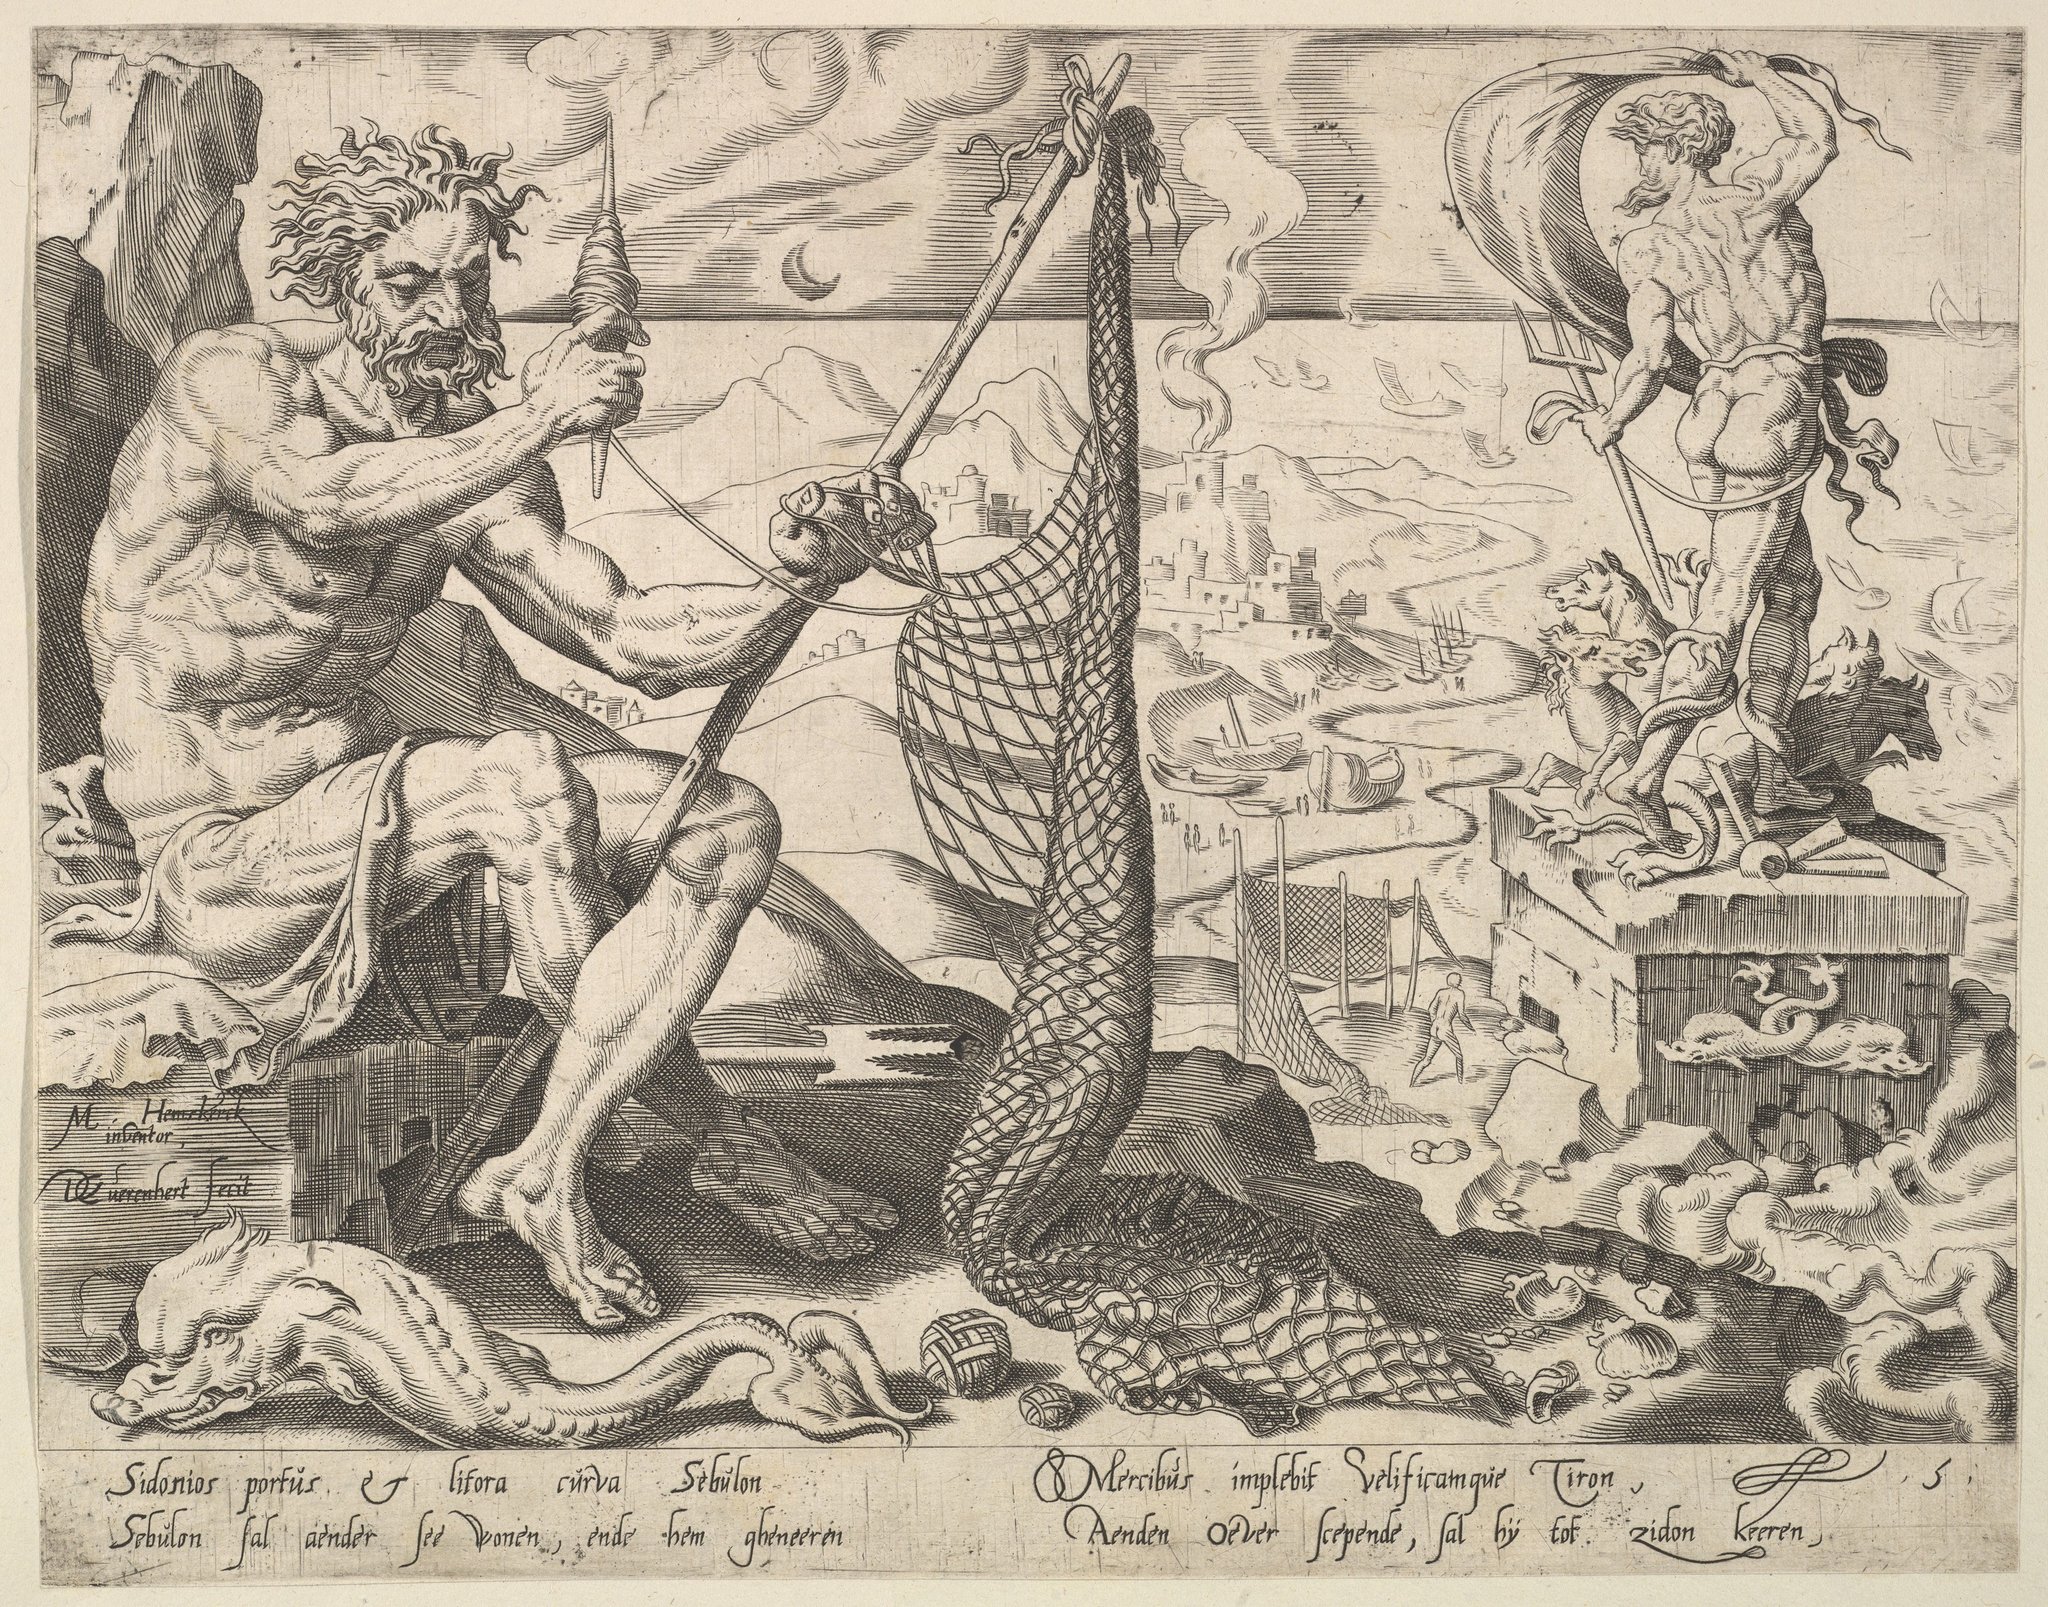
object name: print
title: Zebulun, from "The Twelve Patriarchs"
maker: maarten van heemskerck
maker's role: artist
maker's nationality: netherlandish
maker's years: 1498-1574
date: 1550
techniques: etching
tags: men,male nudes,fish